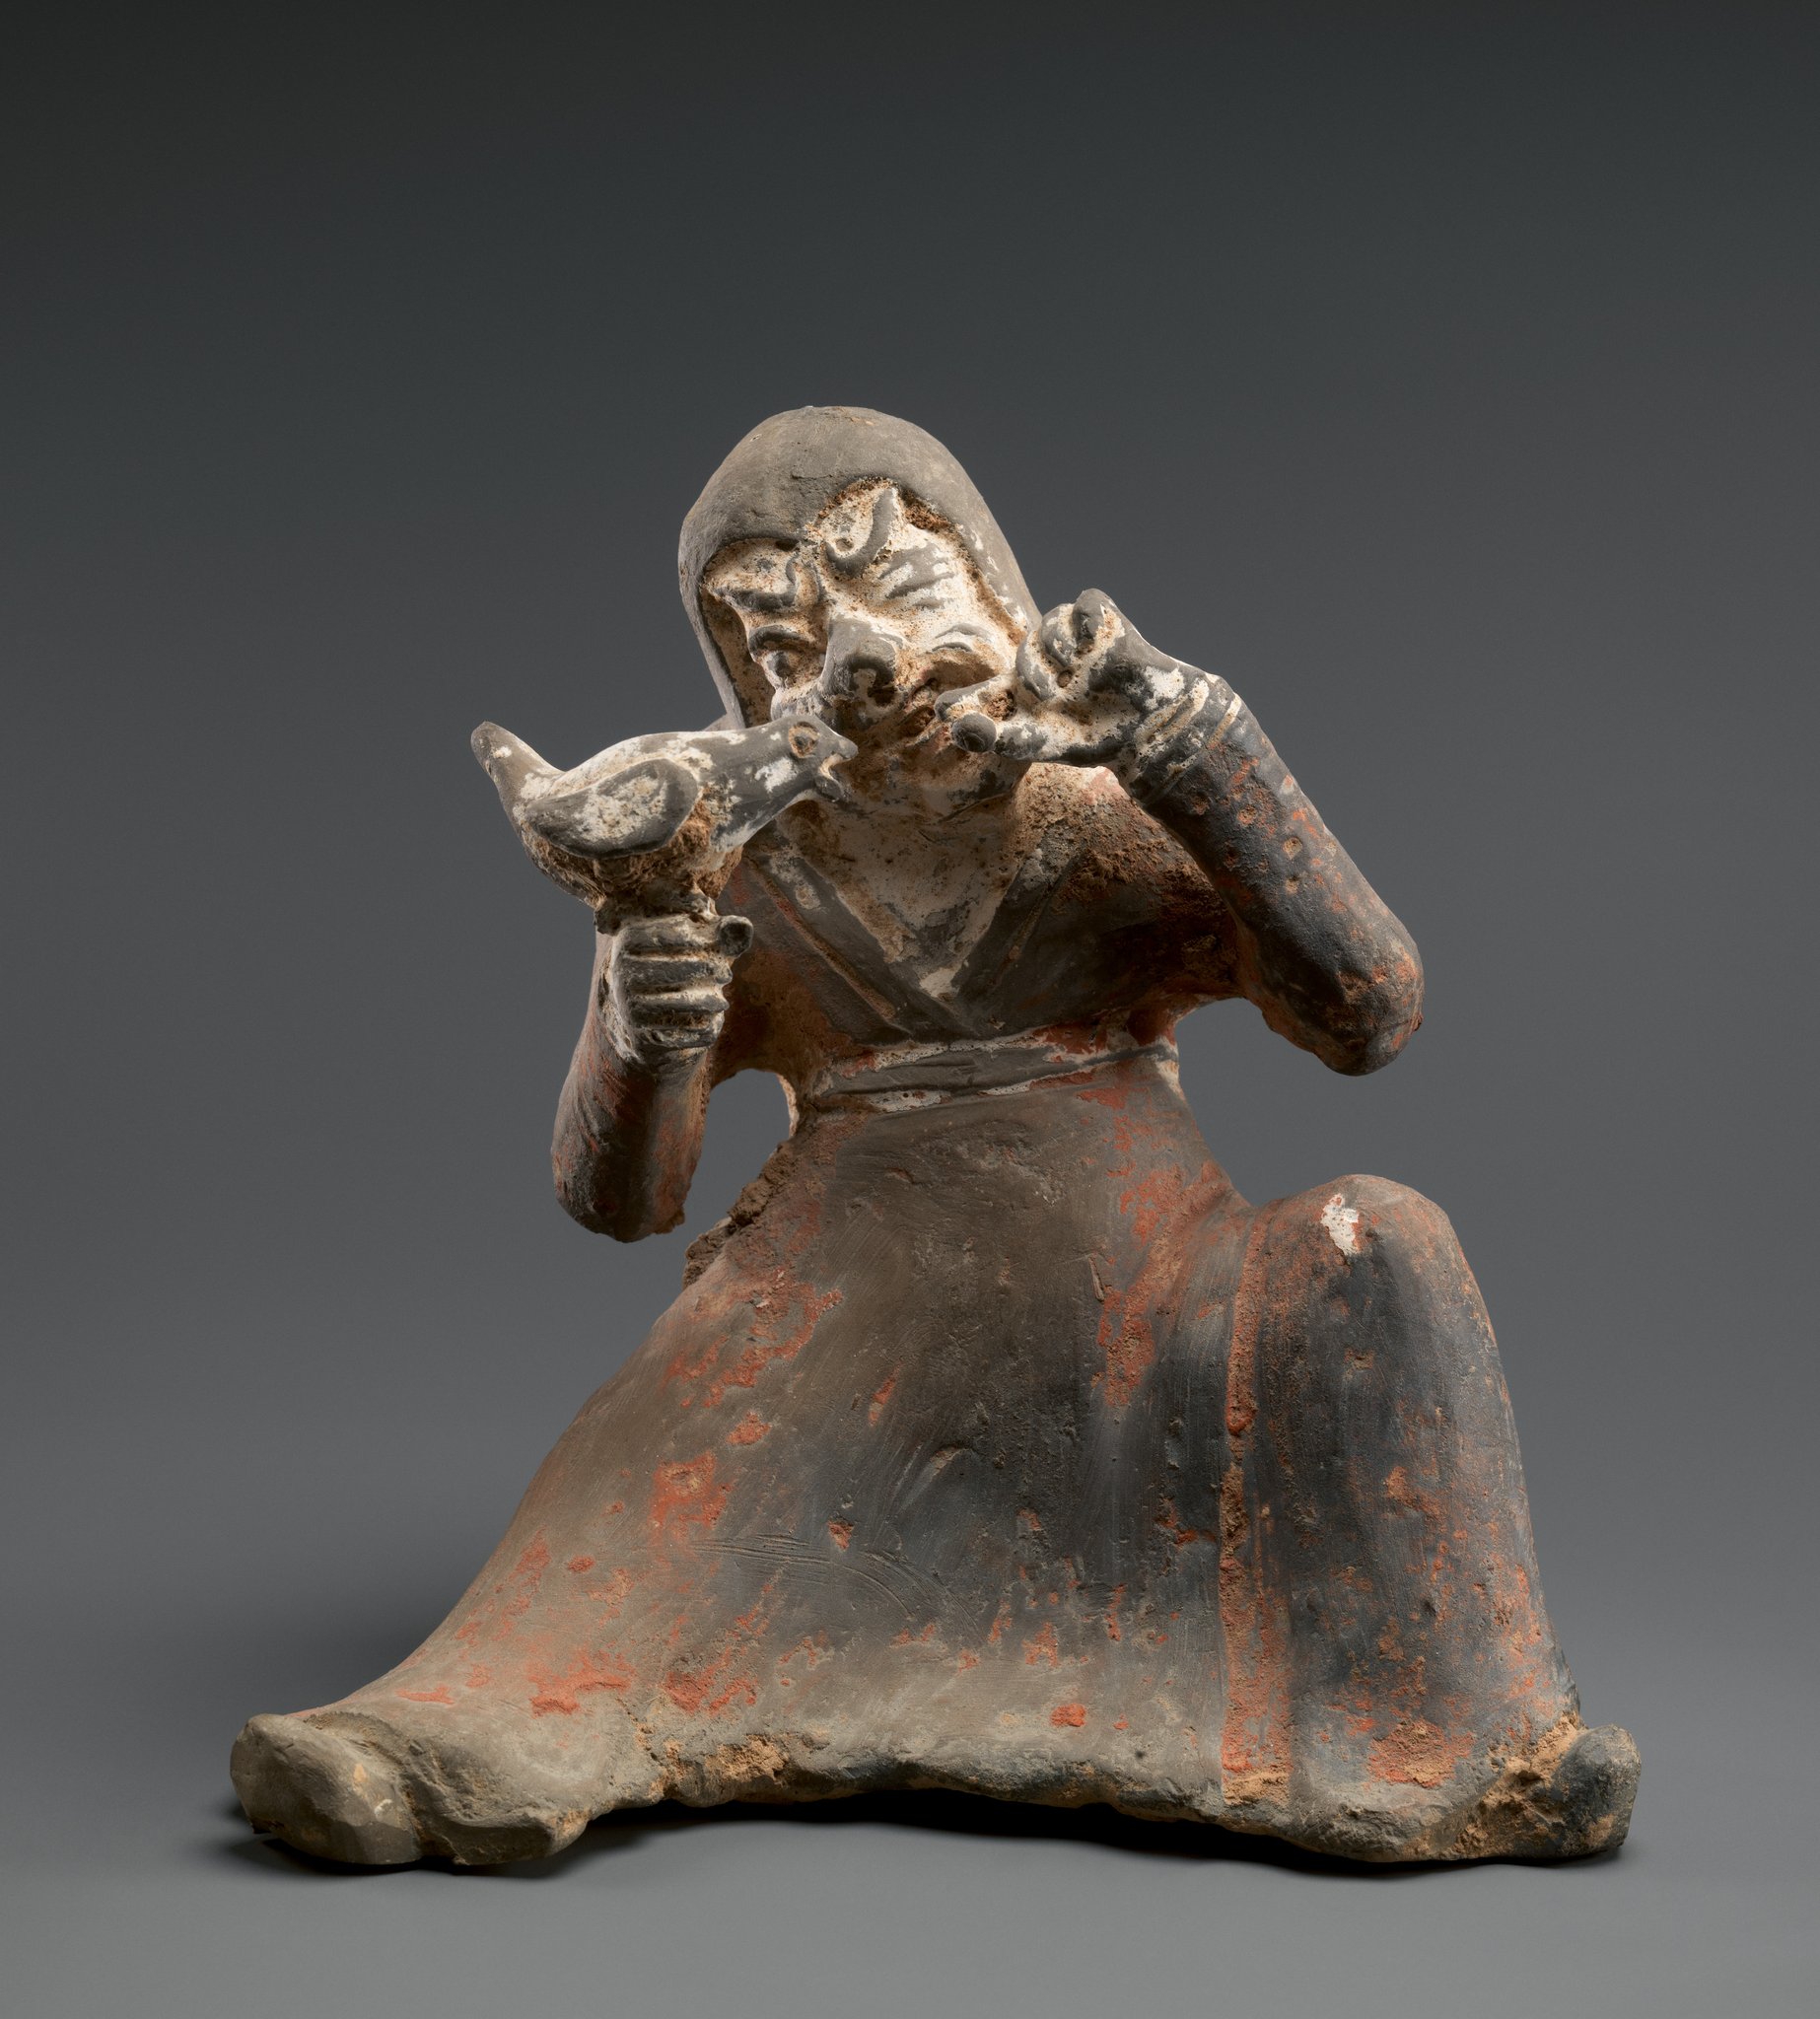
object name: one of a pair of figure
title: Seated Falconer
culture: chinese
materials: earthenware, pigment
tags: human figures,falcons